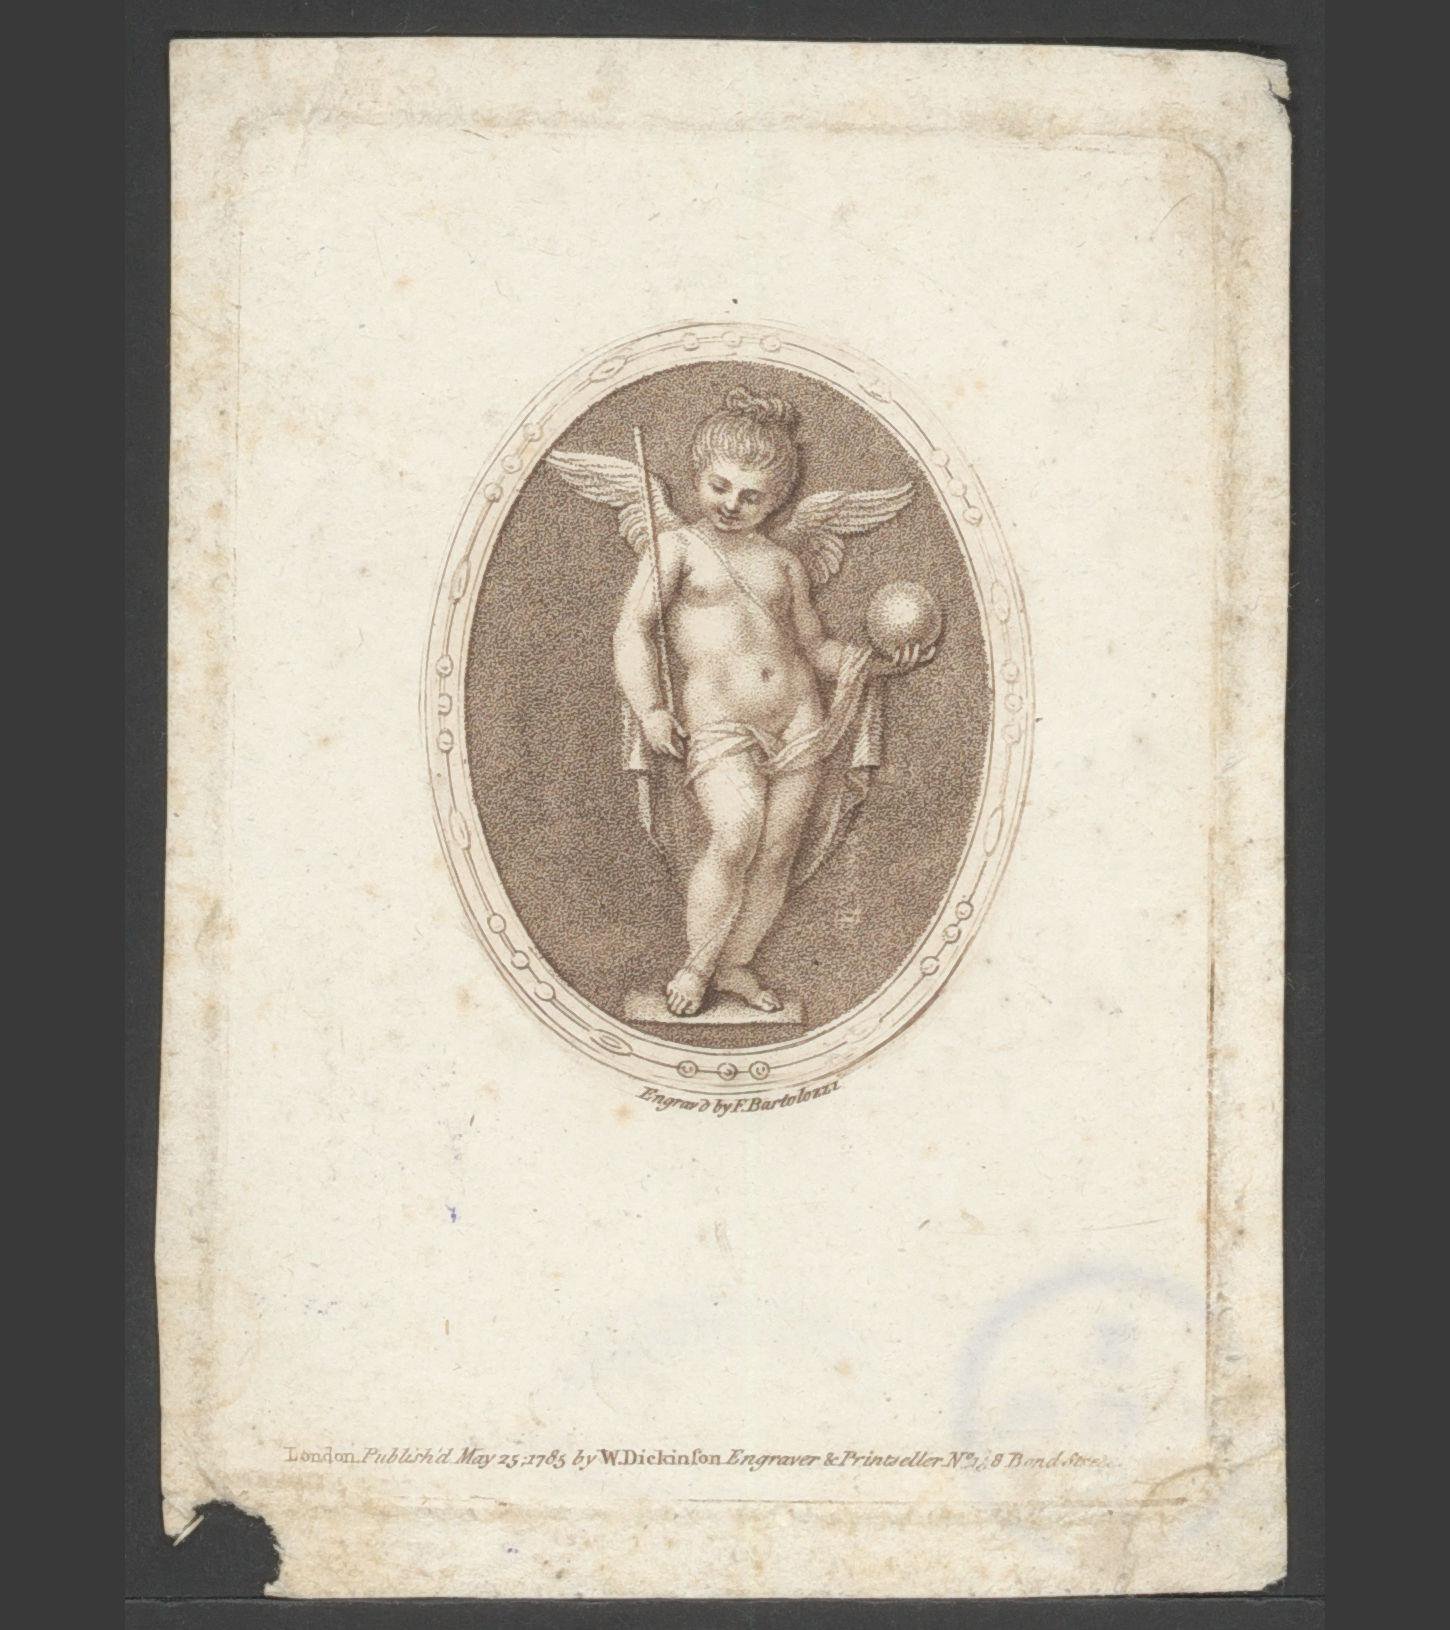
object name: print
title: Vrouwelijke putto met bol en staf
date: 1785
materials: paper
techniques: engraving, etching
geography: london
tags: sphere, globe ~ stereometry, cupids: 'amores', 'amoretti', 'putti'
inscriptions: stamp, collector's mark: Lugt 1641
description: Gevleugelde vrouwelijke putto met bol en staf. In een ovaal. Onderwerpsrubrieken binnen de Atlas Zeden en Gewoonten: Schoone kunsten, Varia.